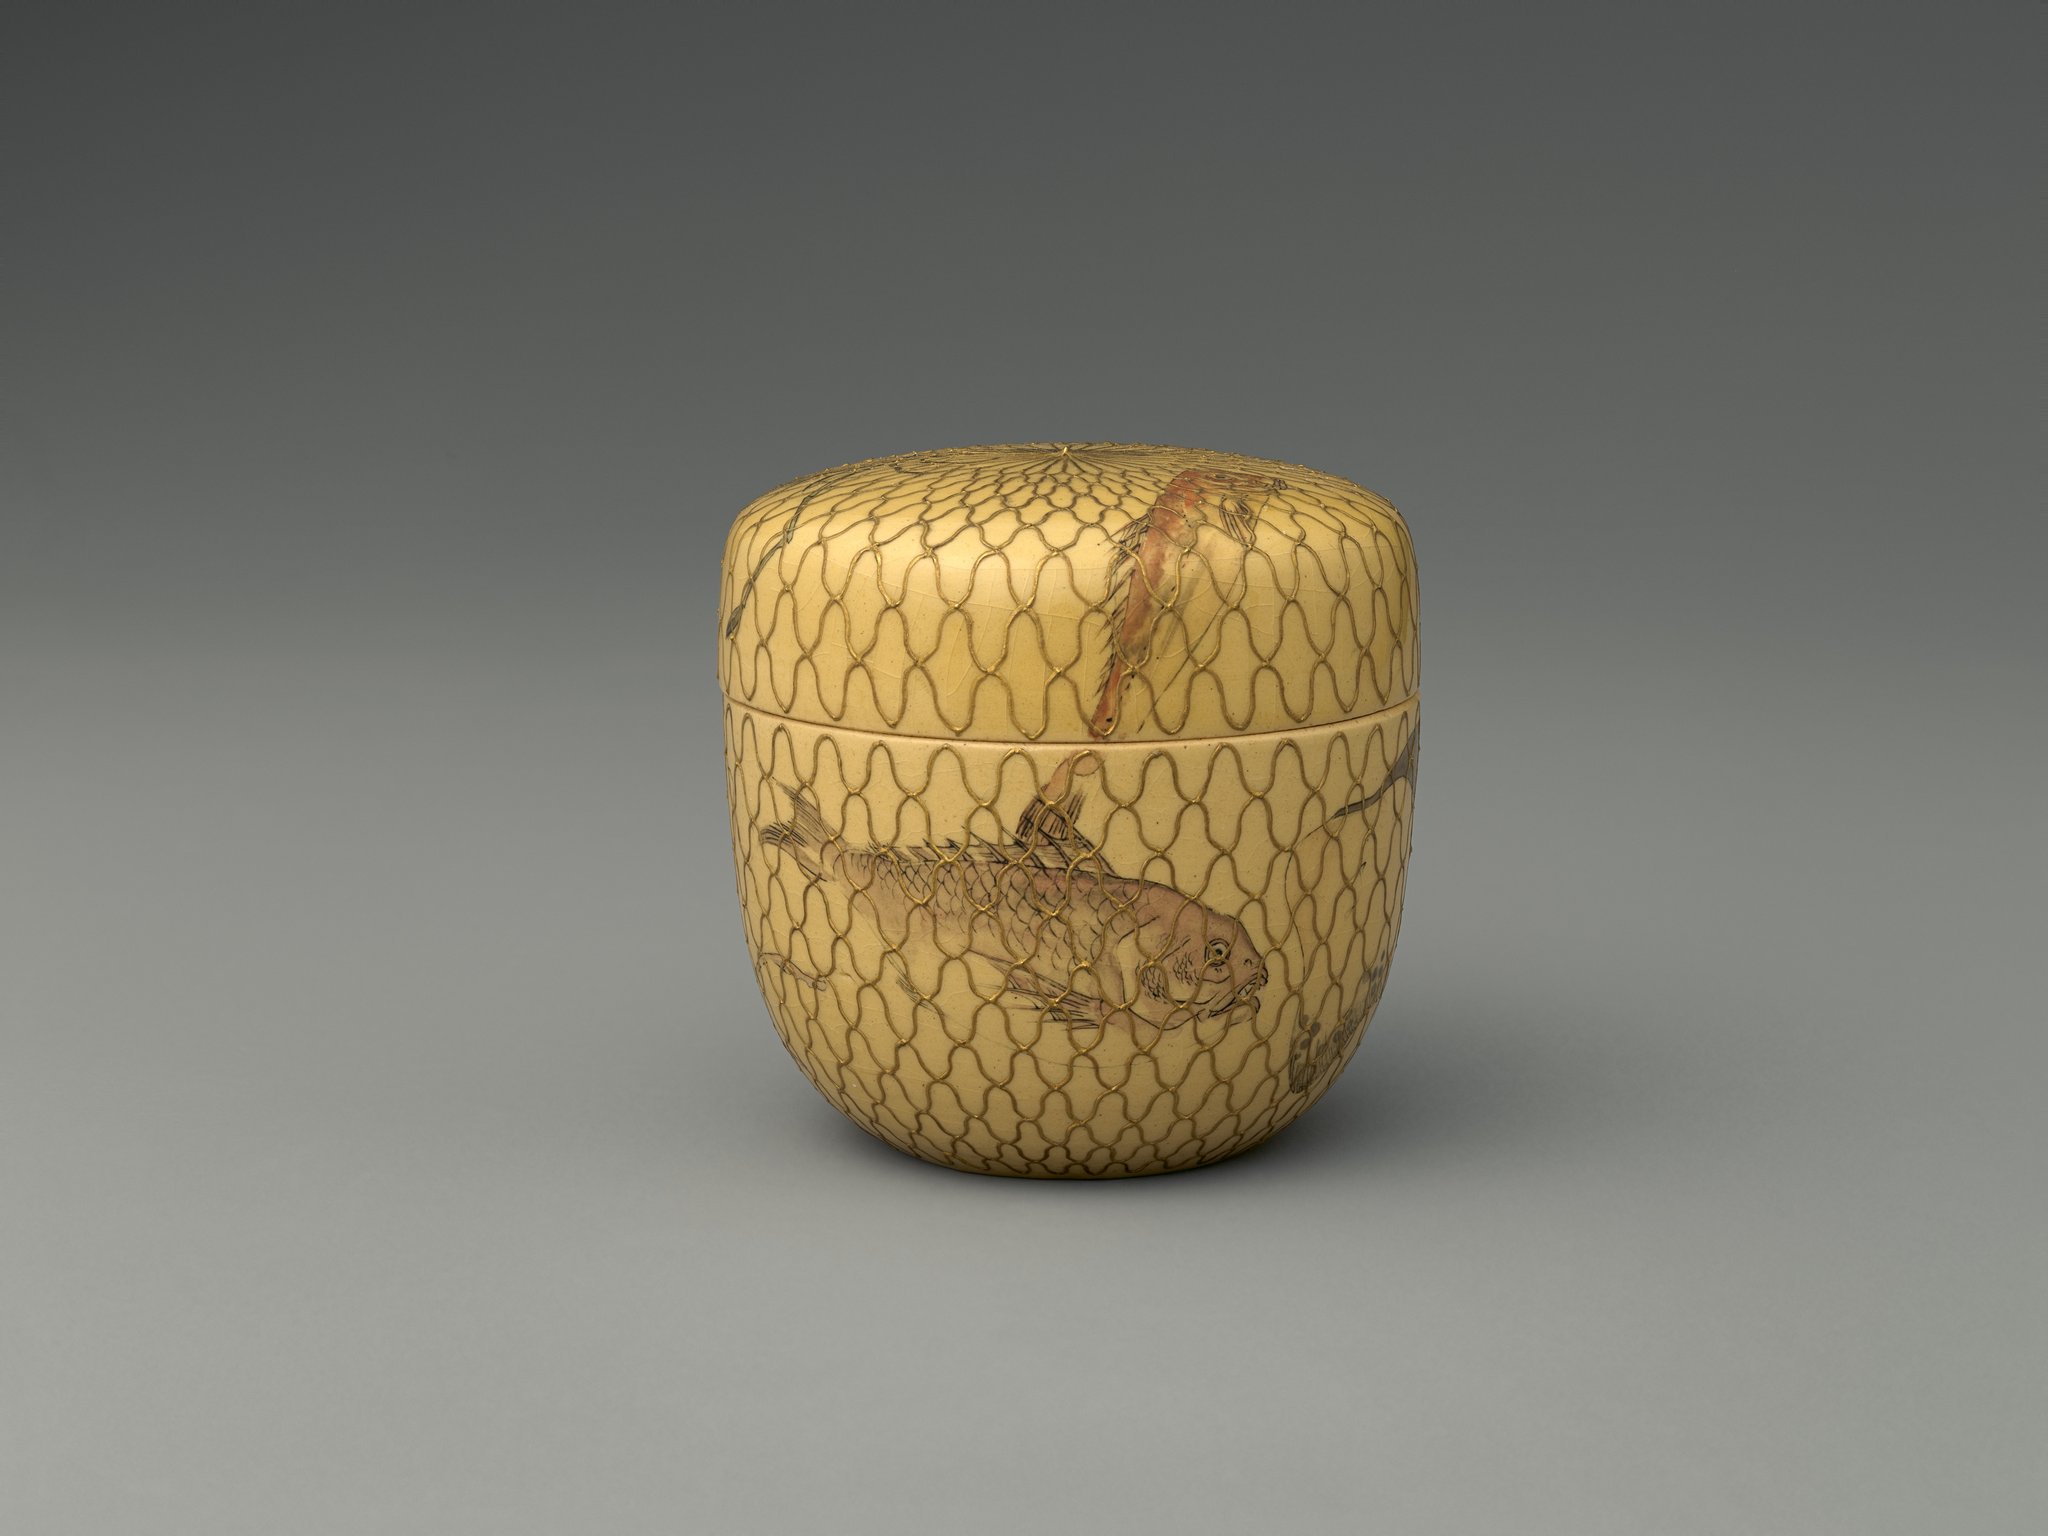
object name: tea caddy natsume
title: Tea Caddy (Natsume)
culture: japanese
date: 1851-1900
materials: enamel, gold, stoneware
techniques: overglaze, polychrome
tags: fish